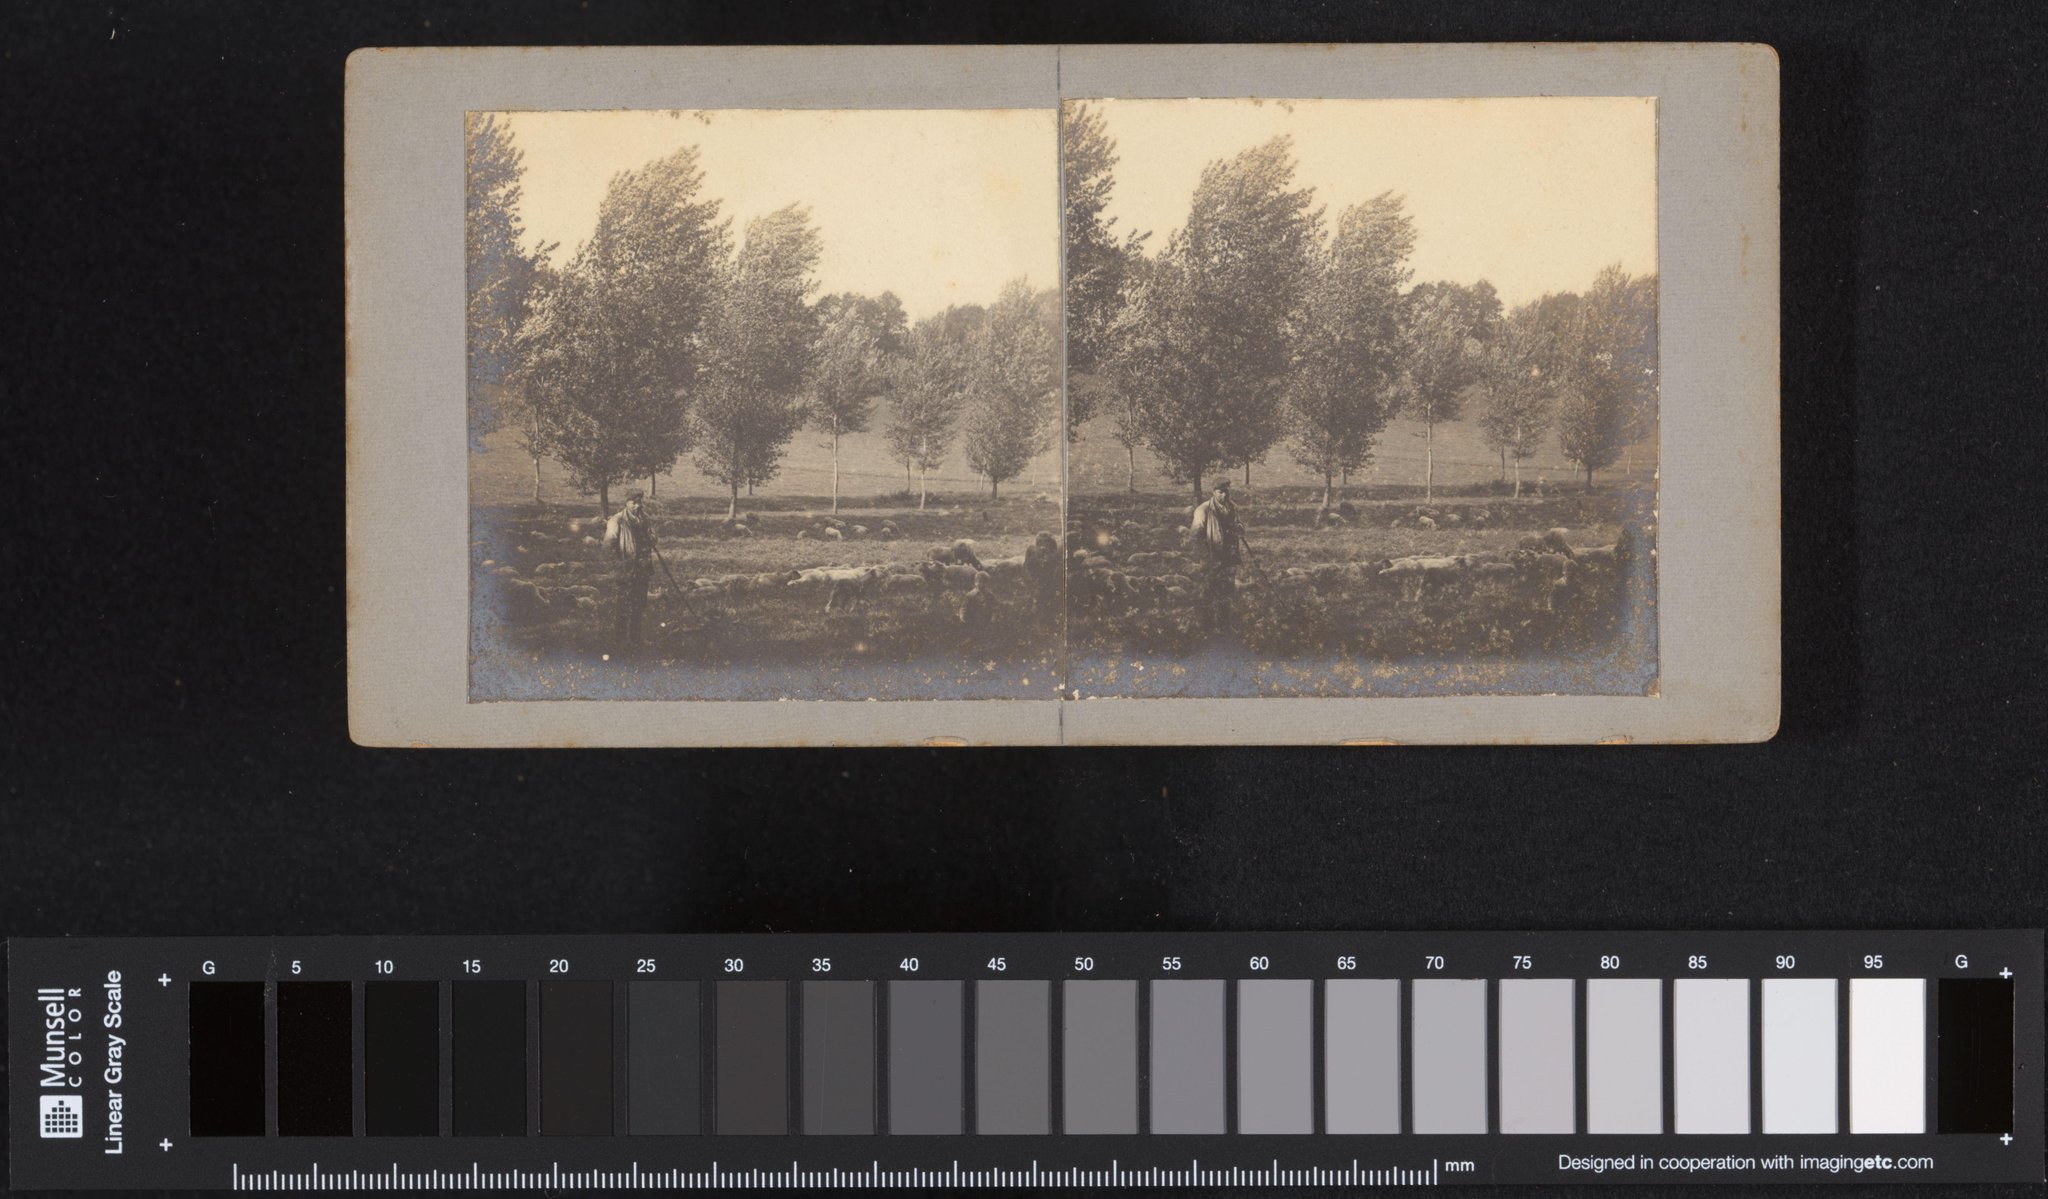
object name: stereograph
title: Schapenherder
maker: robert julius boers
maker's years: 1867-1932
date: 1900-1922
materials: cardboard, photographic support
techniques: gelatin silver print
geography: germany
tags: robert julius boers, germany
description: Schapenherder met kudde schapen in weiland omgeven door bomen, in Europa, waarschijnlijk Duitsland. Onderdeel van een groep stereofoto's van Robert Julius Boers, chef van het staatsbedrijf de Banka-tinwinning op Banka, uit de periode ca. 1900-1922.